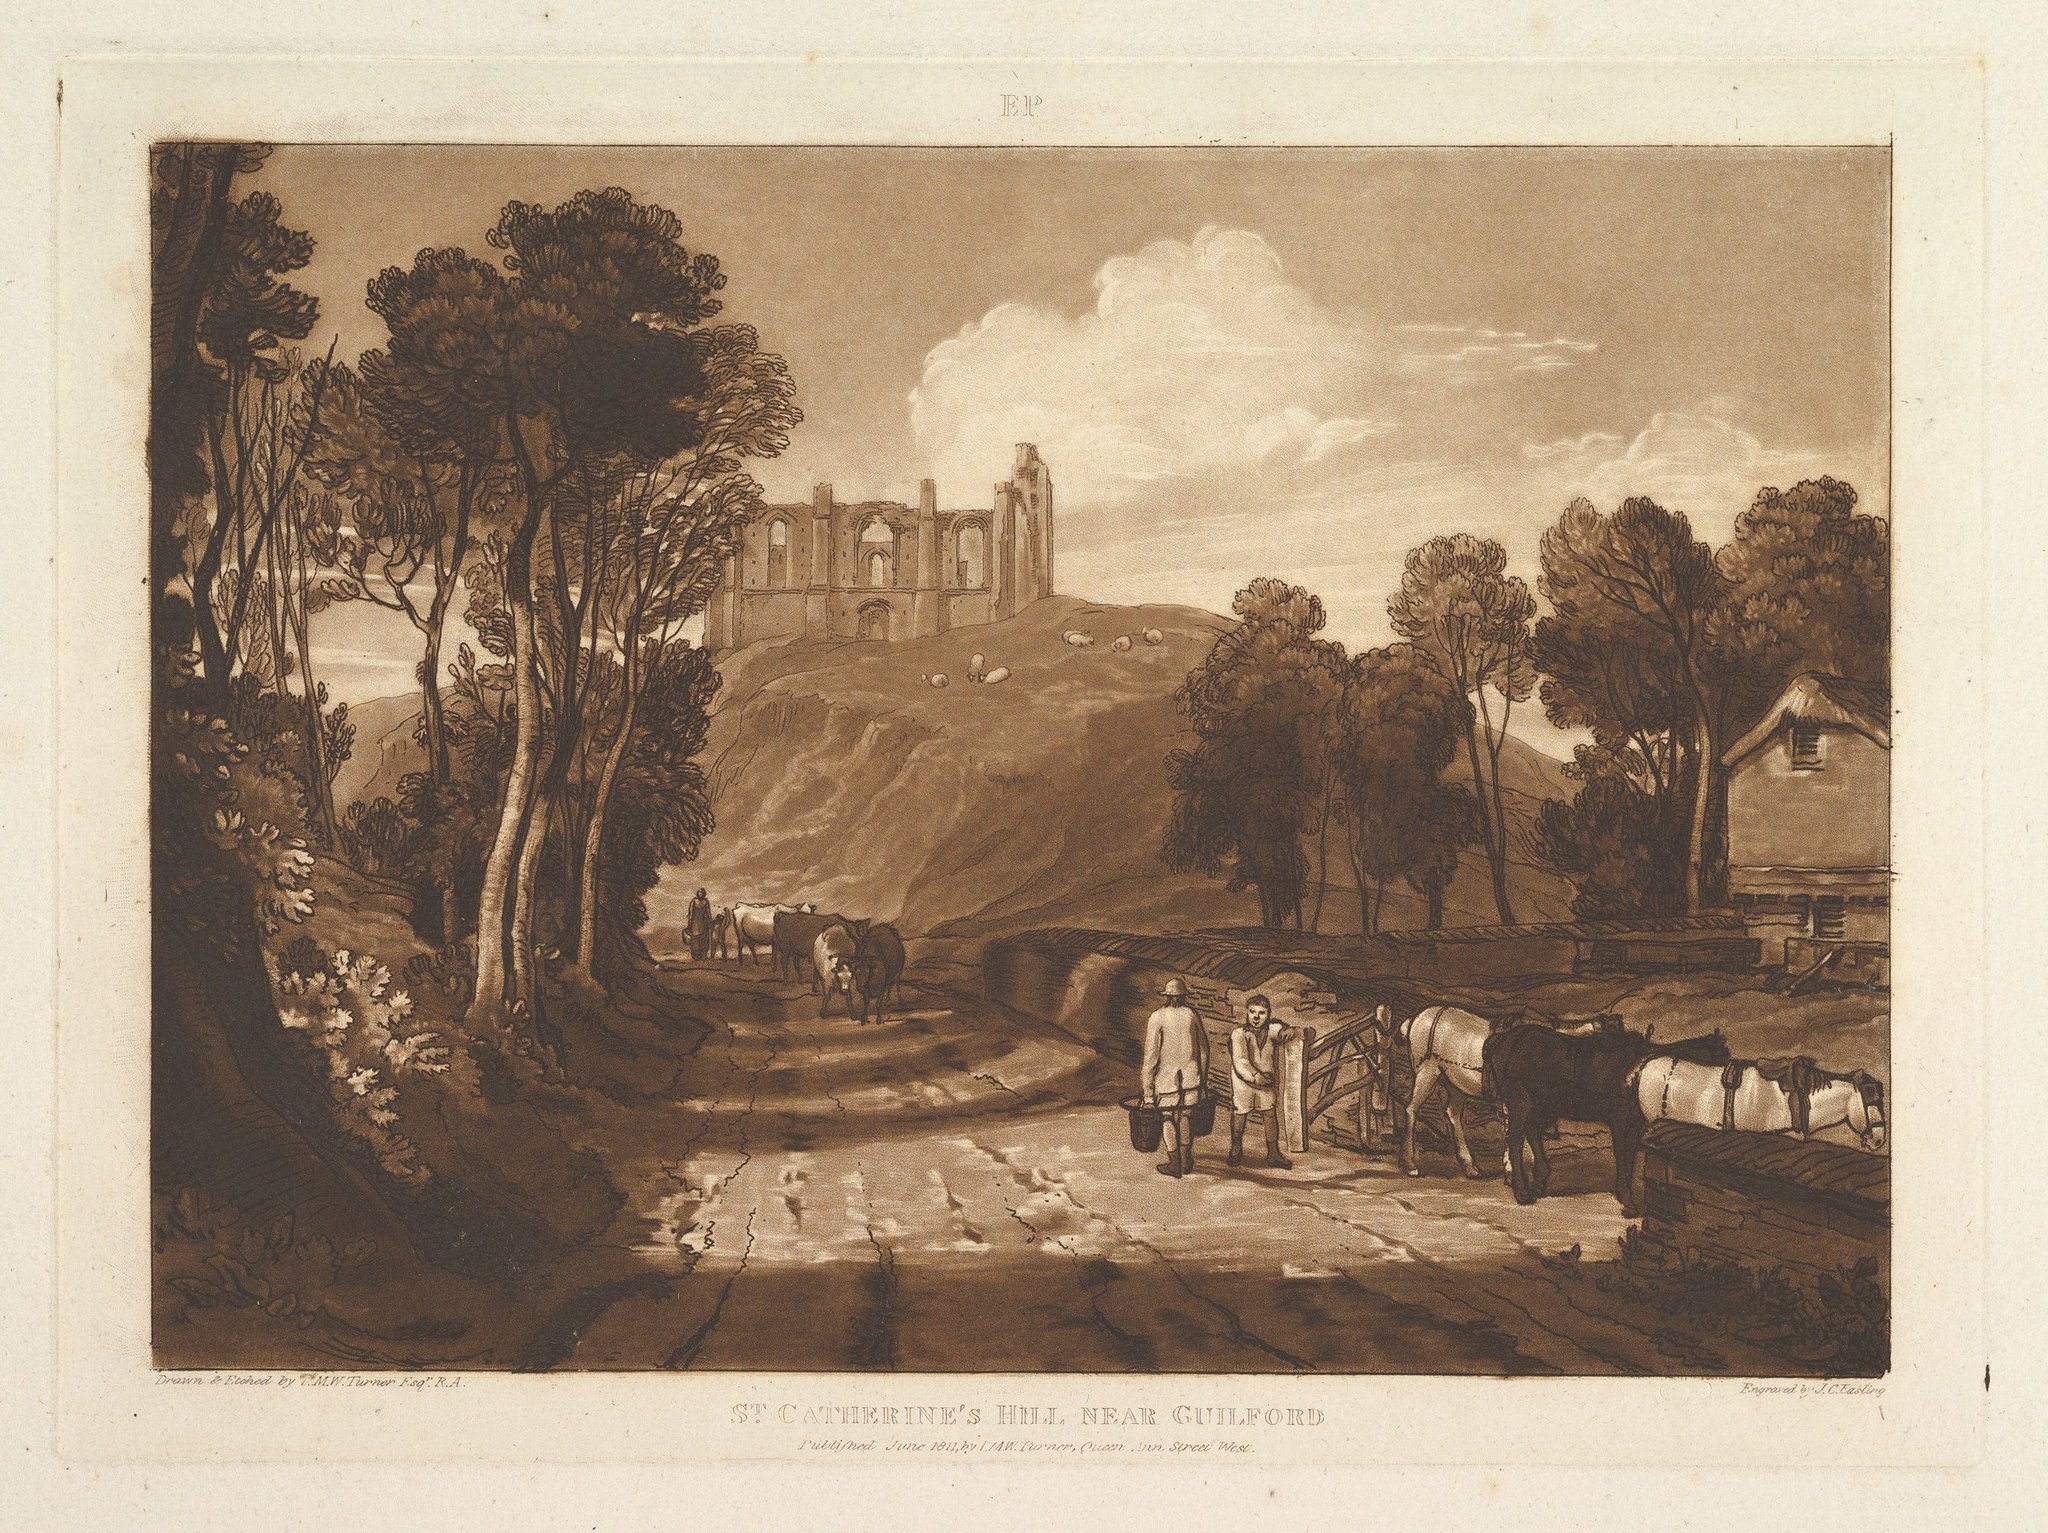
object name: print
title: St. Catharine's Hill near Guilford, part VII, plate 33 from "Liber Studiorum"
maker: joseph mallord william turner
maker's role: artist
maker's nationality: british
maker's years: 1775-1851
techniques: etching, mezzotint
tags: houses,men,horses,hills,trees